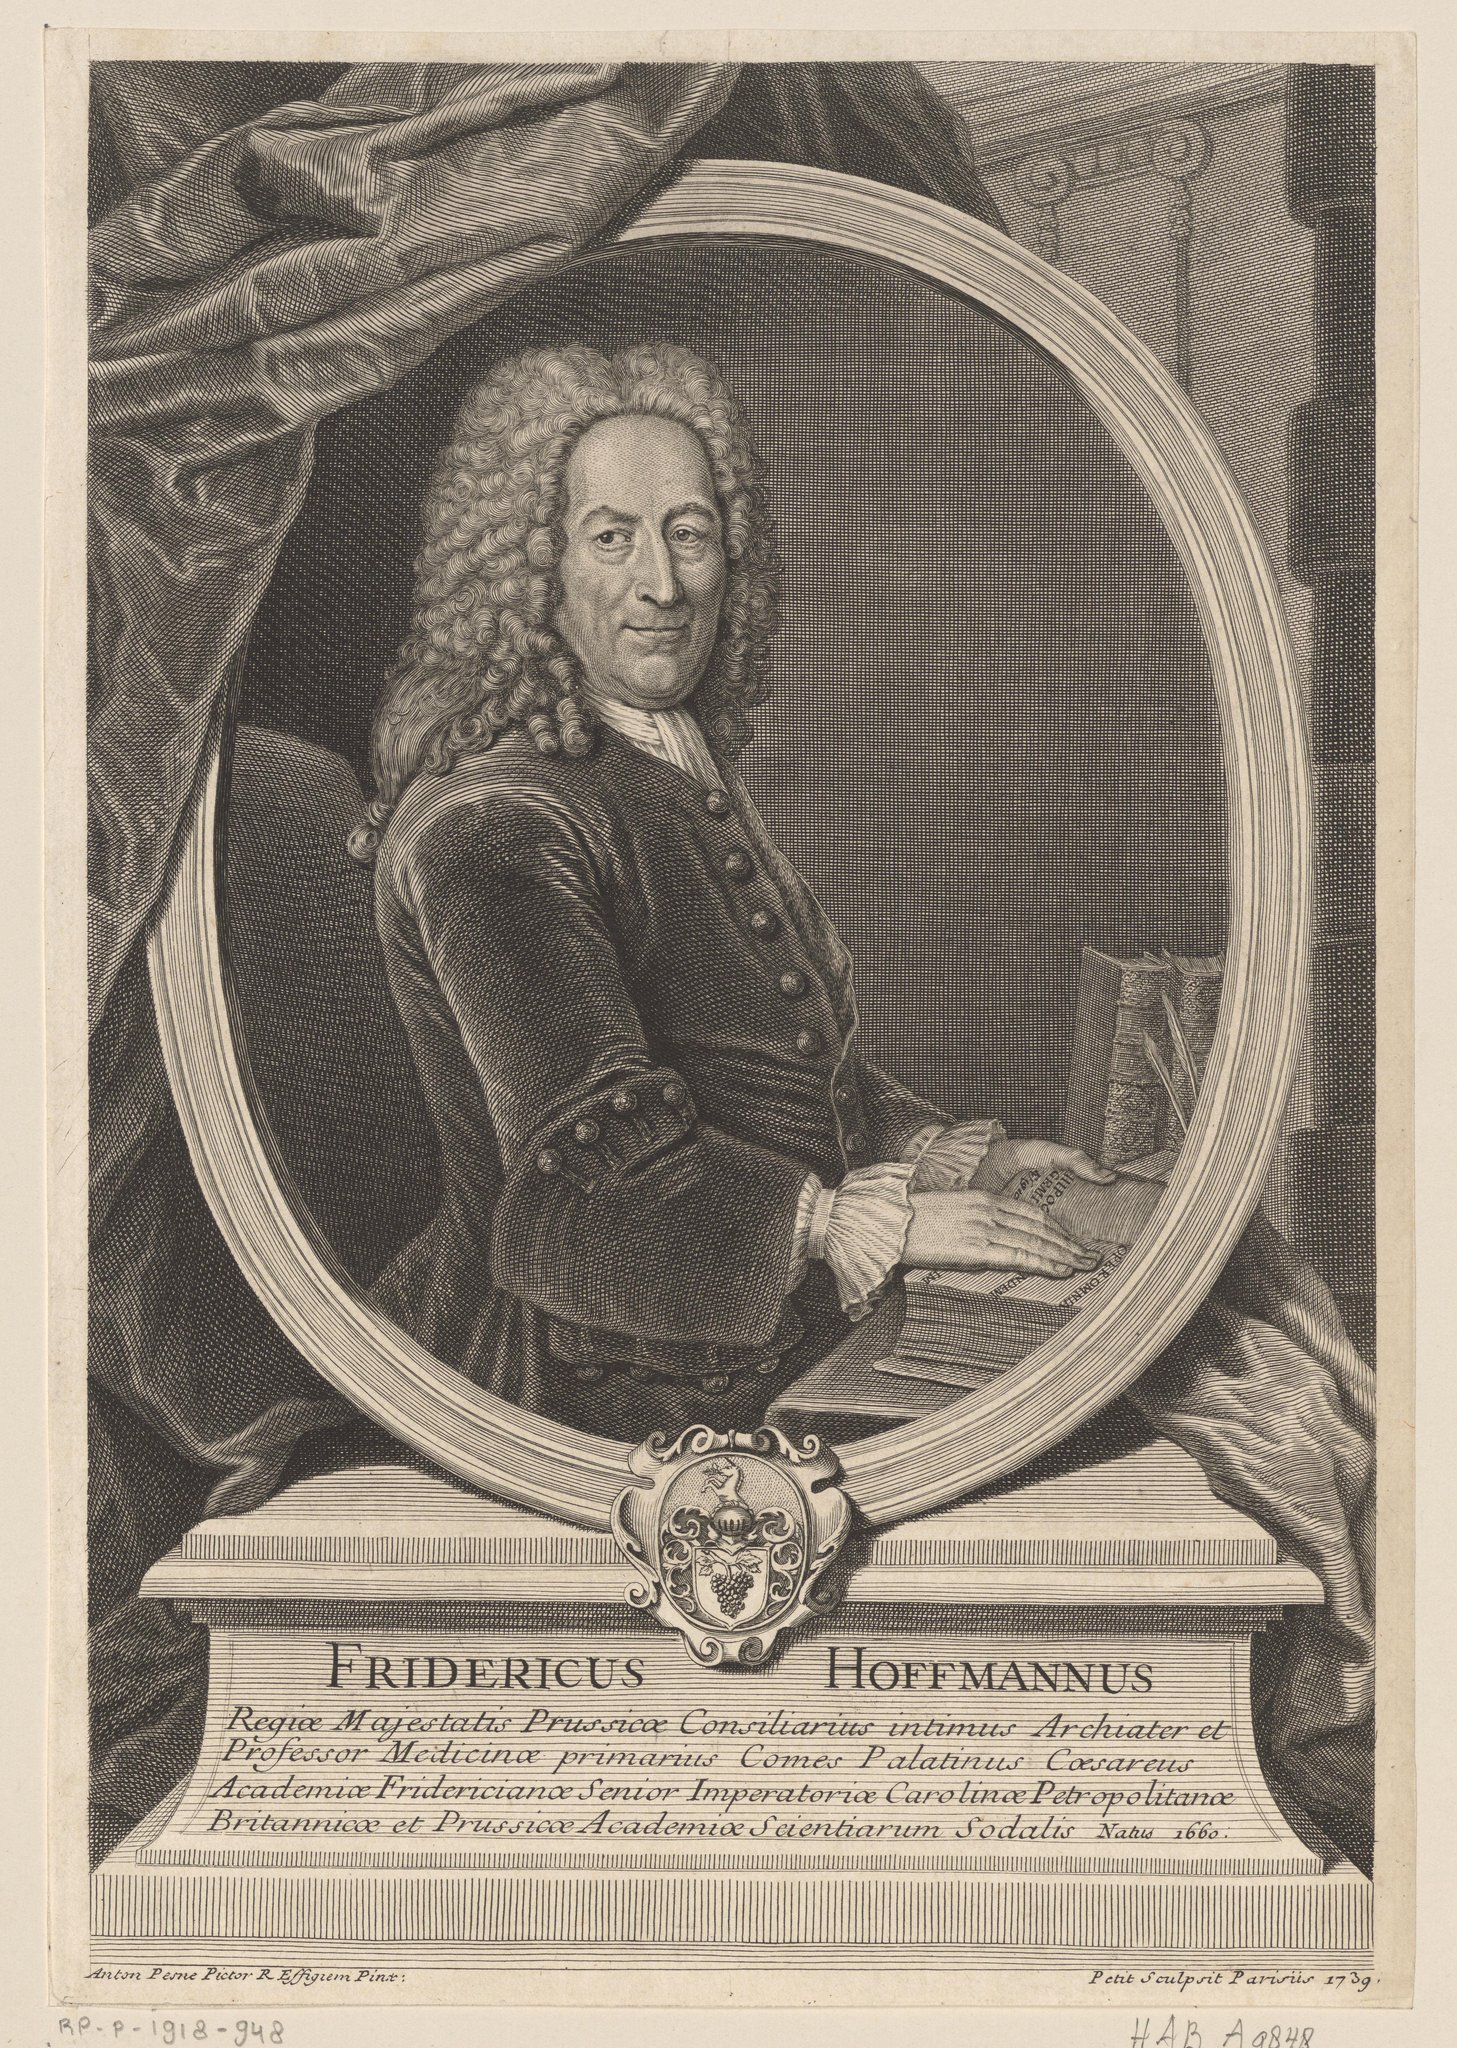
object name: print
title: Portret van Friedrich Hoffmann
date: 1739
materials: paper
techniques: engraving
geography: paris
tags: historical persons, physician, doctor, book, armorial bearing, heraldry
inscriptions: collector's mark: Lugt 2233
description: Prent mogelijk gebruikt in: Hoffmann, Friedrich. Opera omnia physico-medica (...). Genève: gebroeders De Tournes, 1748, dl. 1.